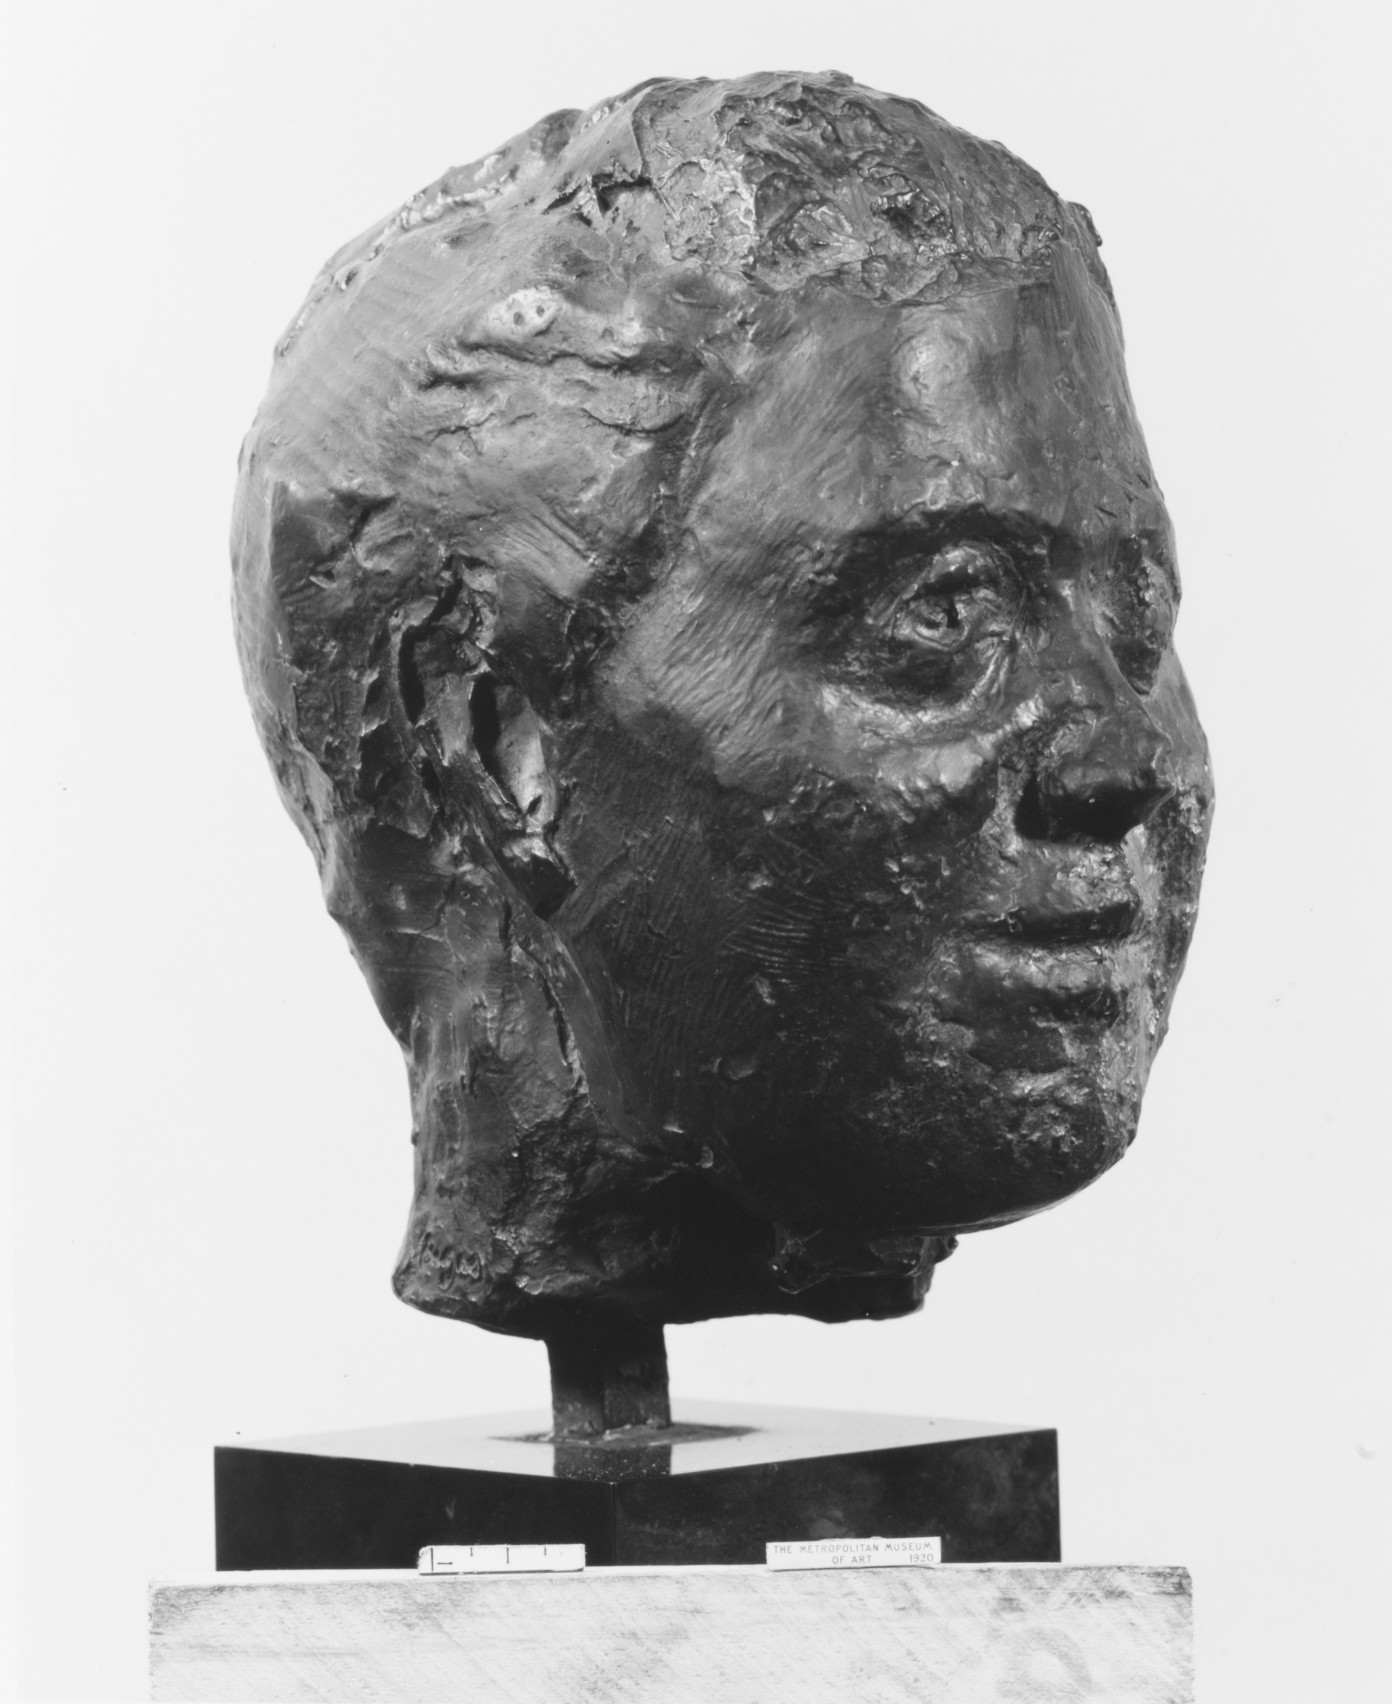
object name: head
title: Study for a Portrait of Mathilde Salle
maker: edgar degas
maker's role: artist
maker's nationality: french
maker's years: 1834-1917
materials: bronze, marble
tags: faces,portraits